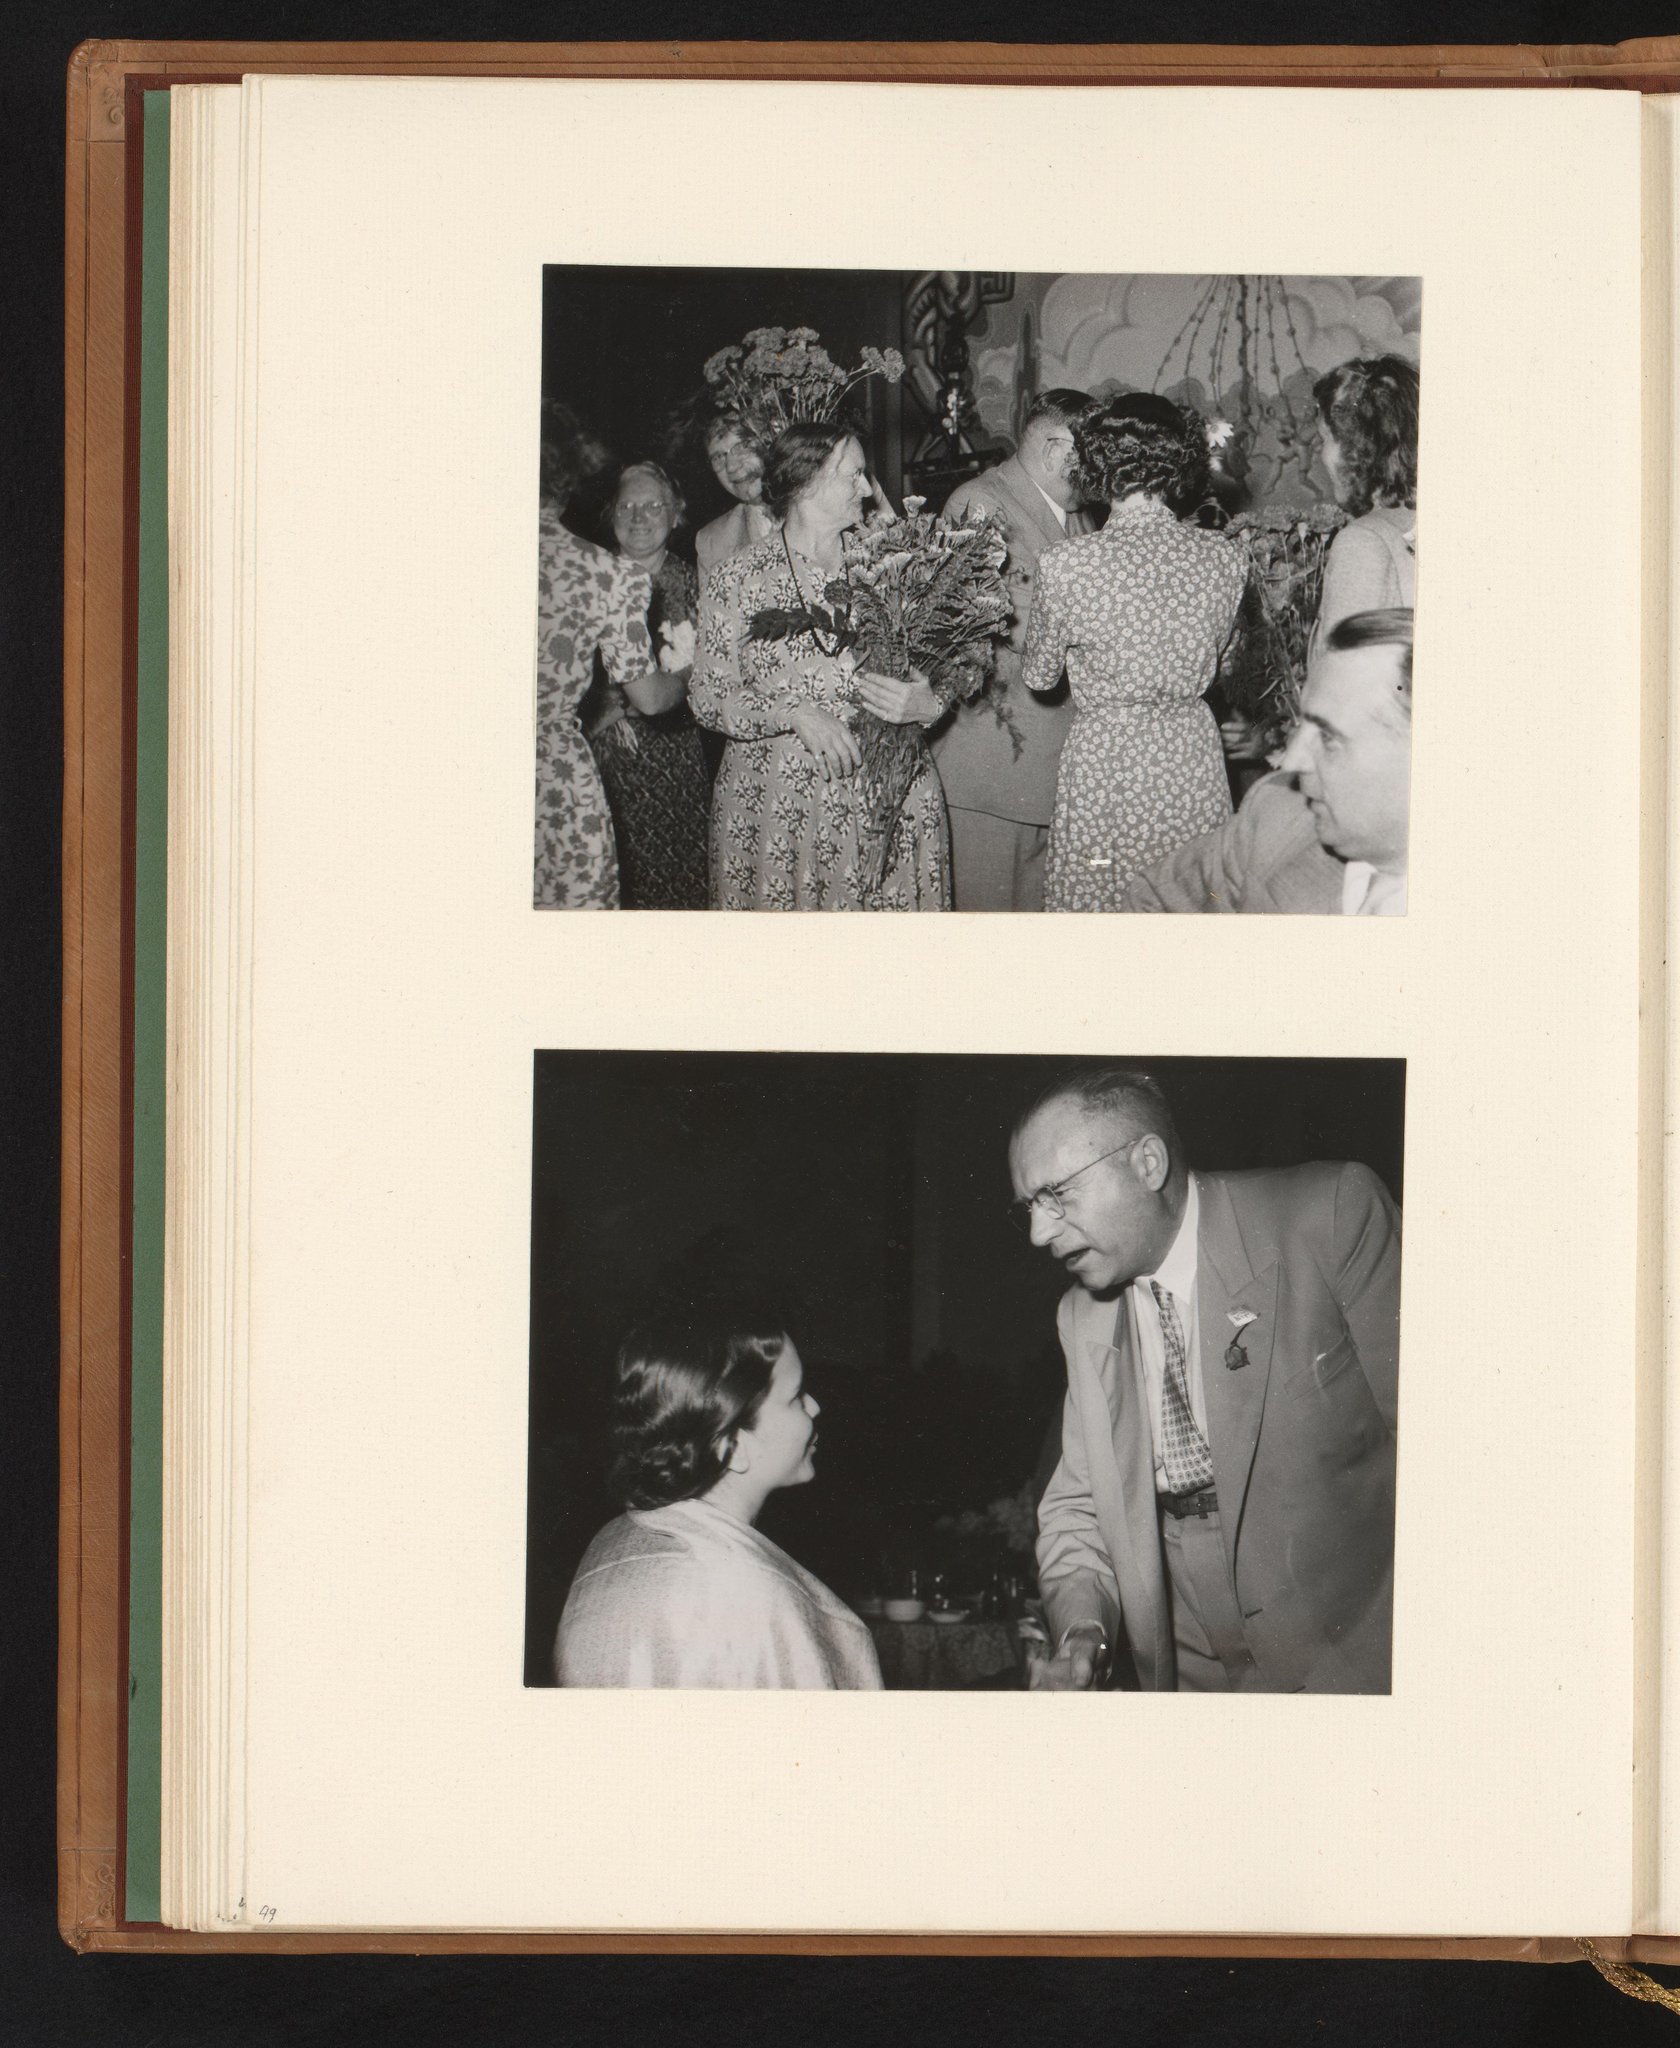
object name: album leaf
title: Afscheid van Kupers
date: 1949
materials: paper, photographic support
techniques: gelatin silver print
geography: amsterdam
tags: modern professional organization, trade union, reception, cocktail party, amsterdam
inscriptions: company name: ‘Fotodienst Het Vrije Volk / Hekelveld 15, Amsterdam’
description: Blad met twee foto's van vrouwen met bossen bloemen (boven) en Kupers de hand schuddend van een jonge vrouw (onder). Onderdeel van het fotoalbum ter gelegenheid van het afscheid van Evert Kupers als voorzitter van de NVV op 14 juli 1949 in Amsterdam.